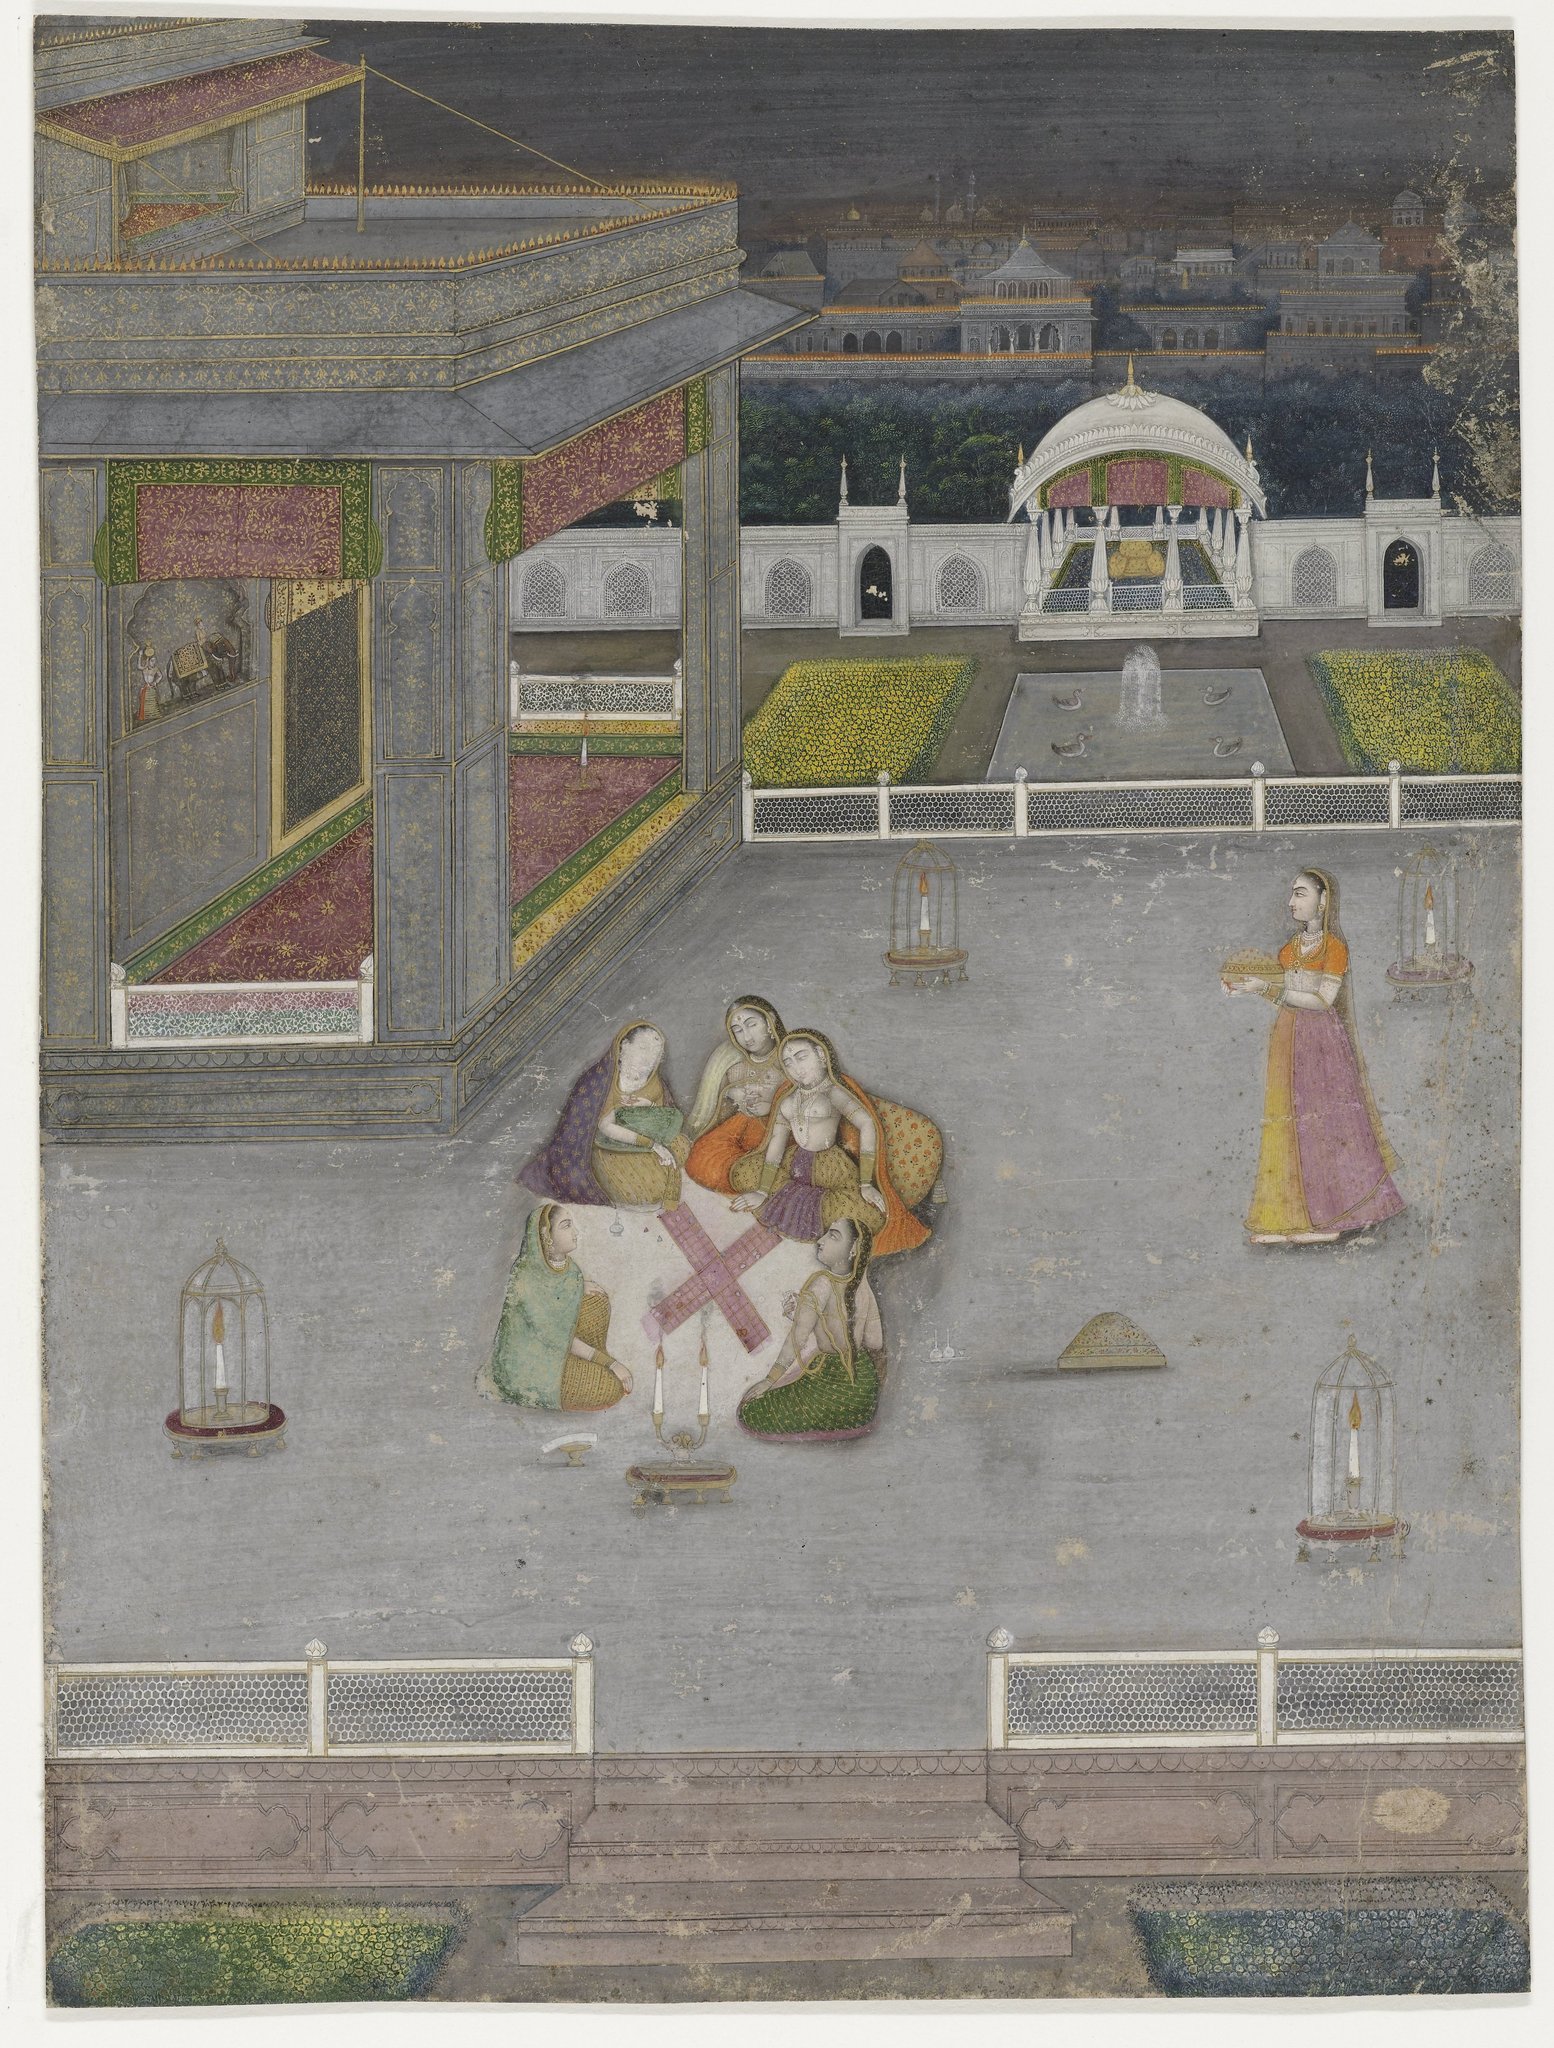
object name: indian miniature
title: Avond in de vrouwenvertrekken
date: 1760-1770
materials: gouache, paper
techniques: brush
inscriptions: inscription: ‘.’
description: Op een ruime binnenplaats van een paleis spelen vier vrouwen een bordspel. De vrouw rechts vooraan heeft drie langwerpige dobbelstenen in de hand, klaar om te werpen. De vrouw rechts van haar zit geleund tegen een rolkussen. Zij is de belangrijkste dame. Het spel dat hier gespeeld wordt heet Chaupar of Pacisi. Het is nacht, maar overal staan lampen om het terras te verlichten. Op de achtergrond zijn op de muren van de stad een immense hoeveelheid lichtjes geplaatst. Waarschijnlijk wordt hier het Islamitische feest Shab-i-Barat gevierd.